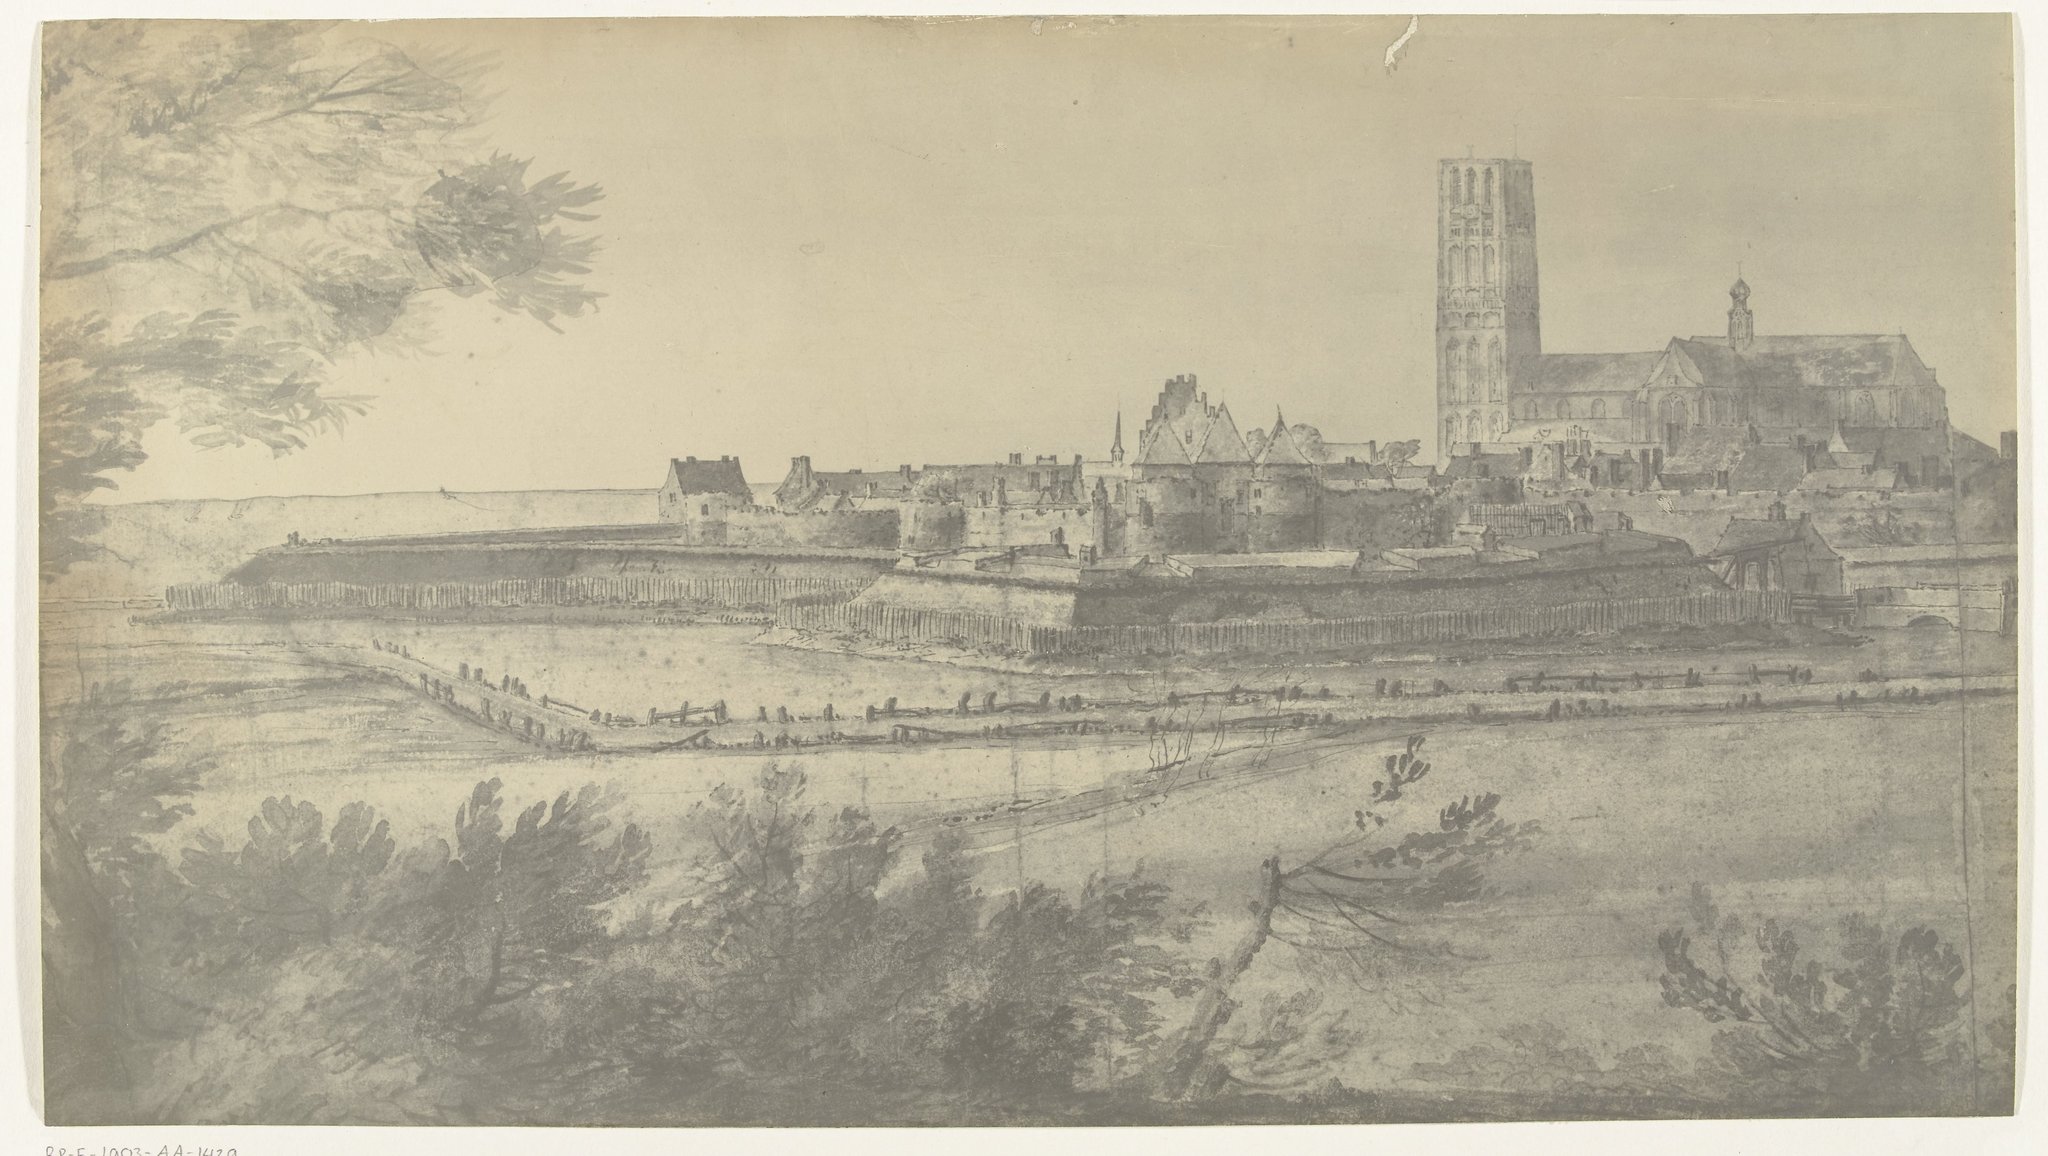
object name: photograph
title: Gezicht op Harderwijk, 1672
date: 1900-1903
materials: paper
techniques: gelatin silver print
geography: france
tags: lodewijk xiv (koning van frankrijk), city-view, and landscape with man-made constructions, rampjaar (disaster year)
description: Niet in Frederik Muller; door het RPK toegevoegd nummer. Onderdeel van een groep van ca. 50 foto's van tekeningen van de Franse inval in de Nederlanden in 1672 door Adam Frans van der Meulen, bewaard in de Manufacture Nationale des Gobelins te Parijs.